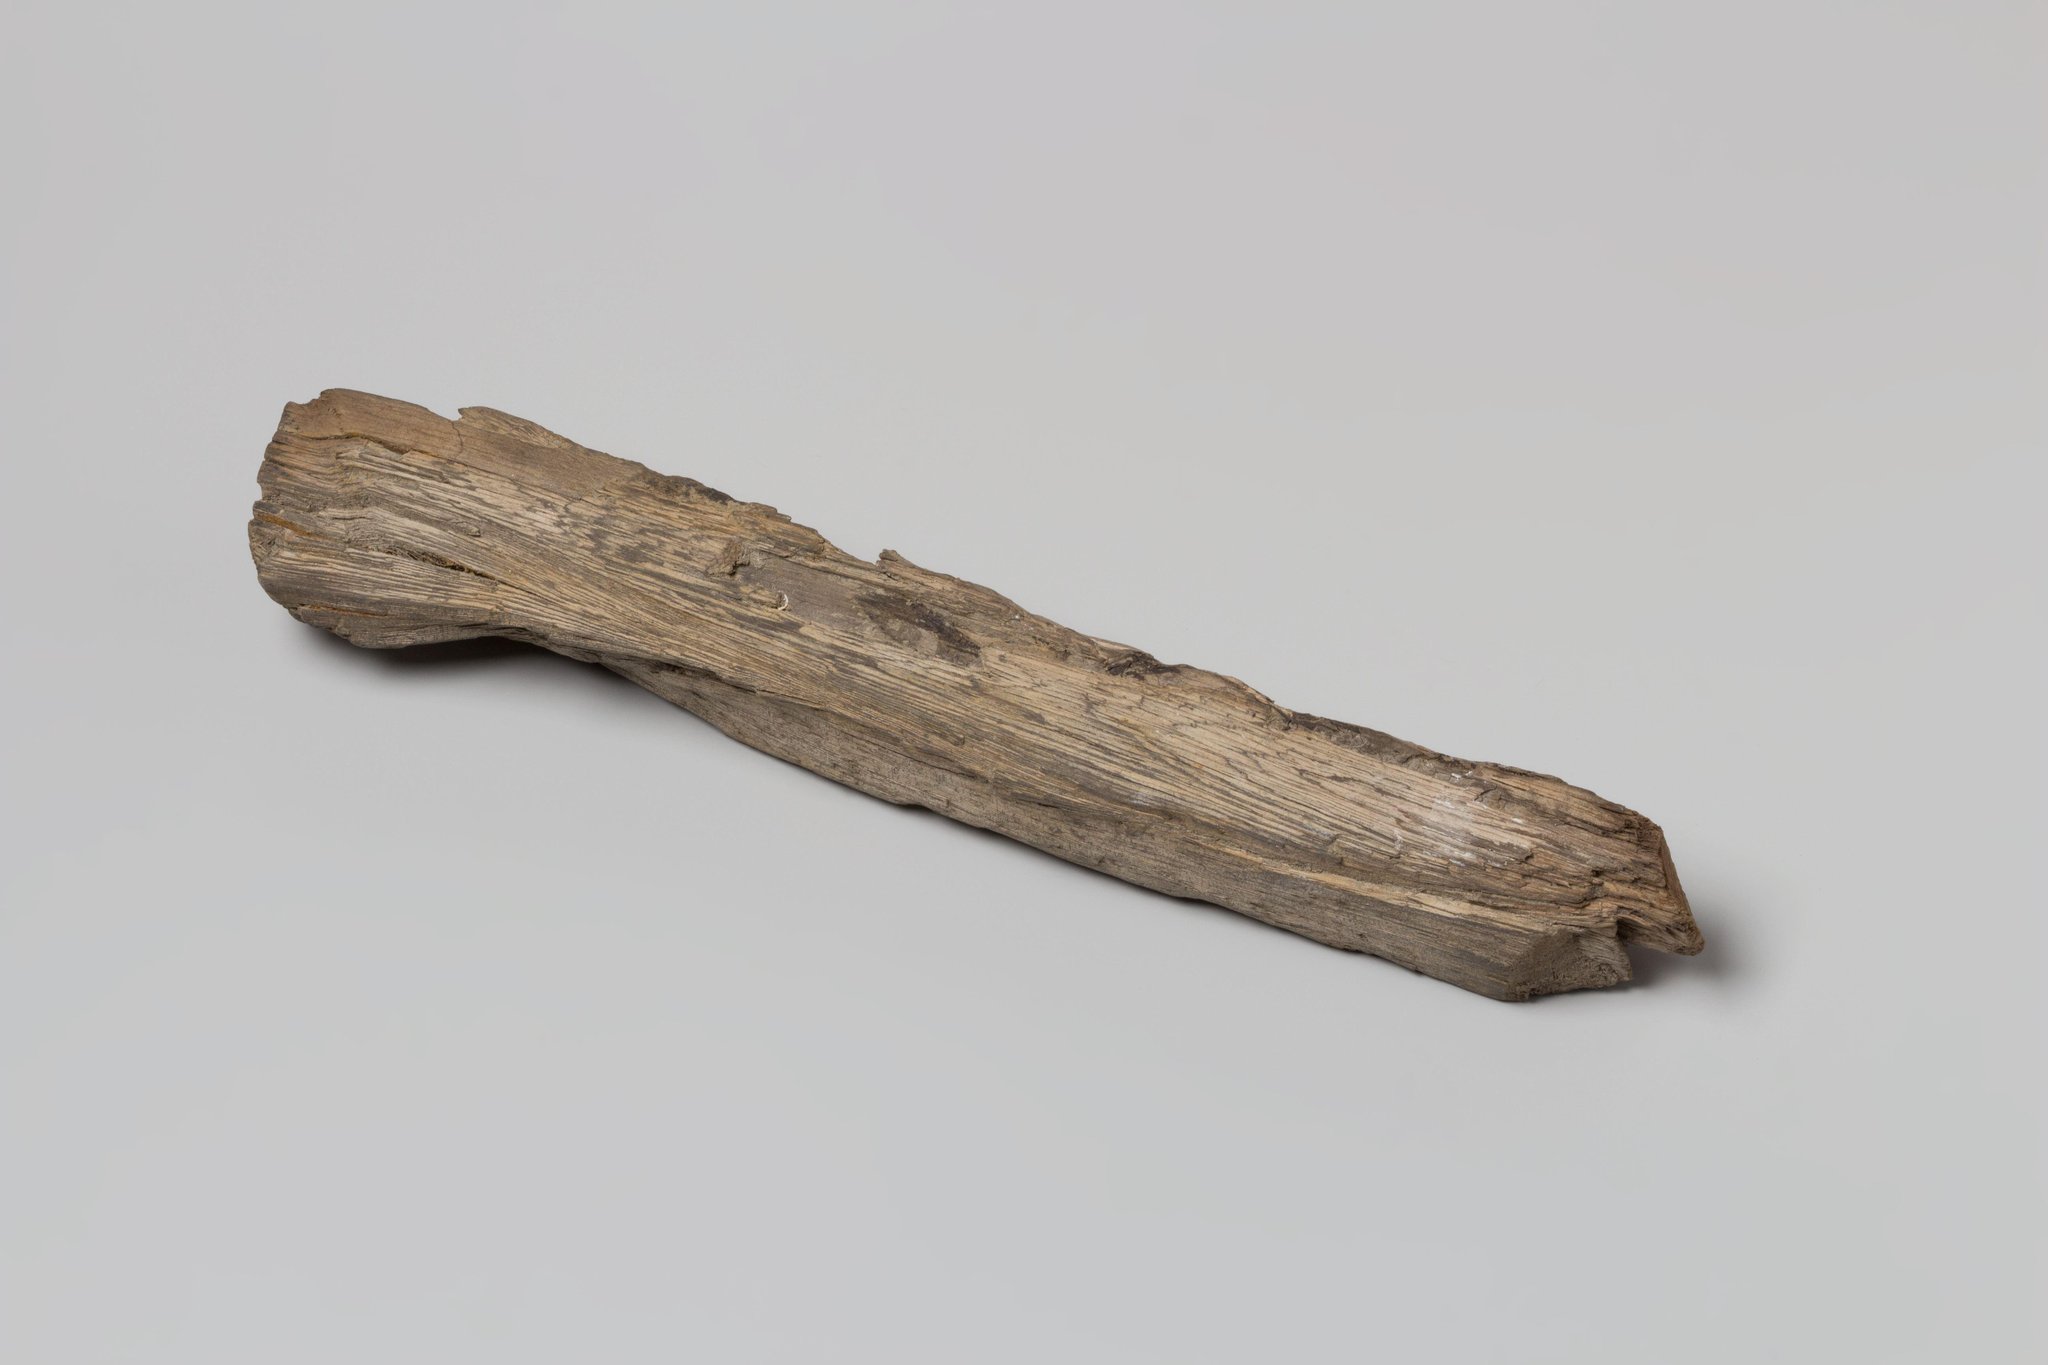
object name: case furniture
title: Houten fragment van een kast uit het wrak van de Oost-Indiëvaarder 't Vliegend Hart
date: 1700-1735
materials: wood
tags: 't vliegend hart (schip), verenigde oostindische compagnie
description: Het langwerpige, bijna vierkante stuk hout is grijs-bruin-zwart verkleurd (er zit een soort aanslag op). De houtsoort is Europees grenen (Pinus sylvestris). Volgens de vondstverwerking van de opgraving maakte het onderdeel uit van een kast.